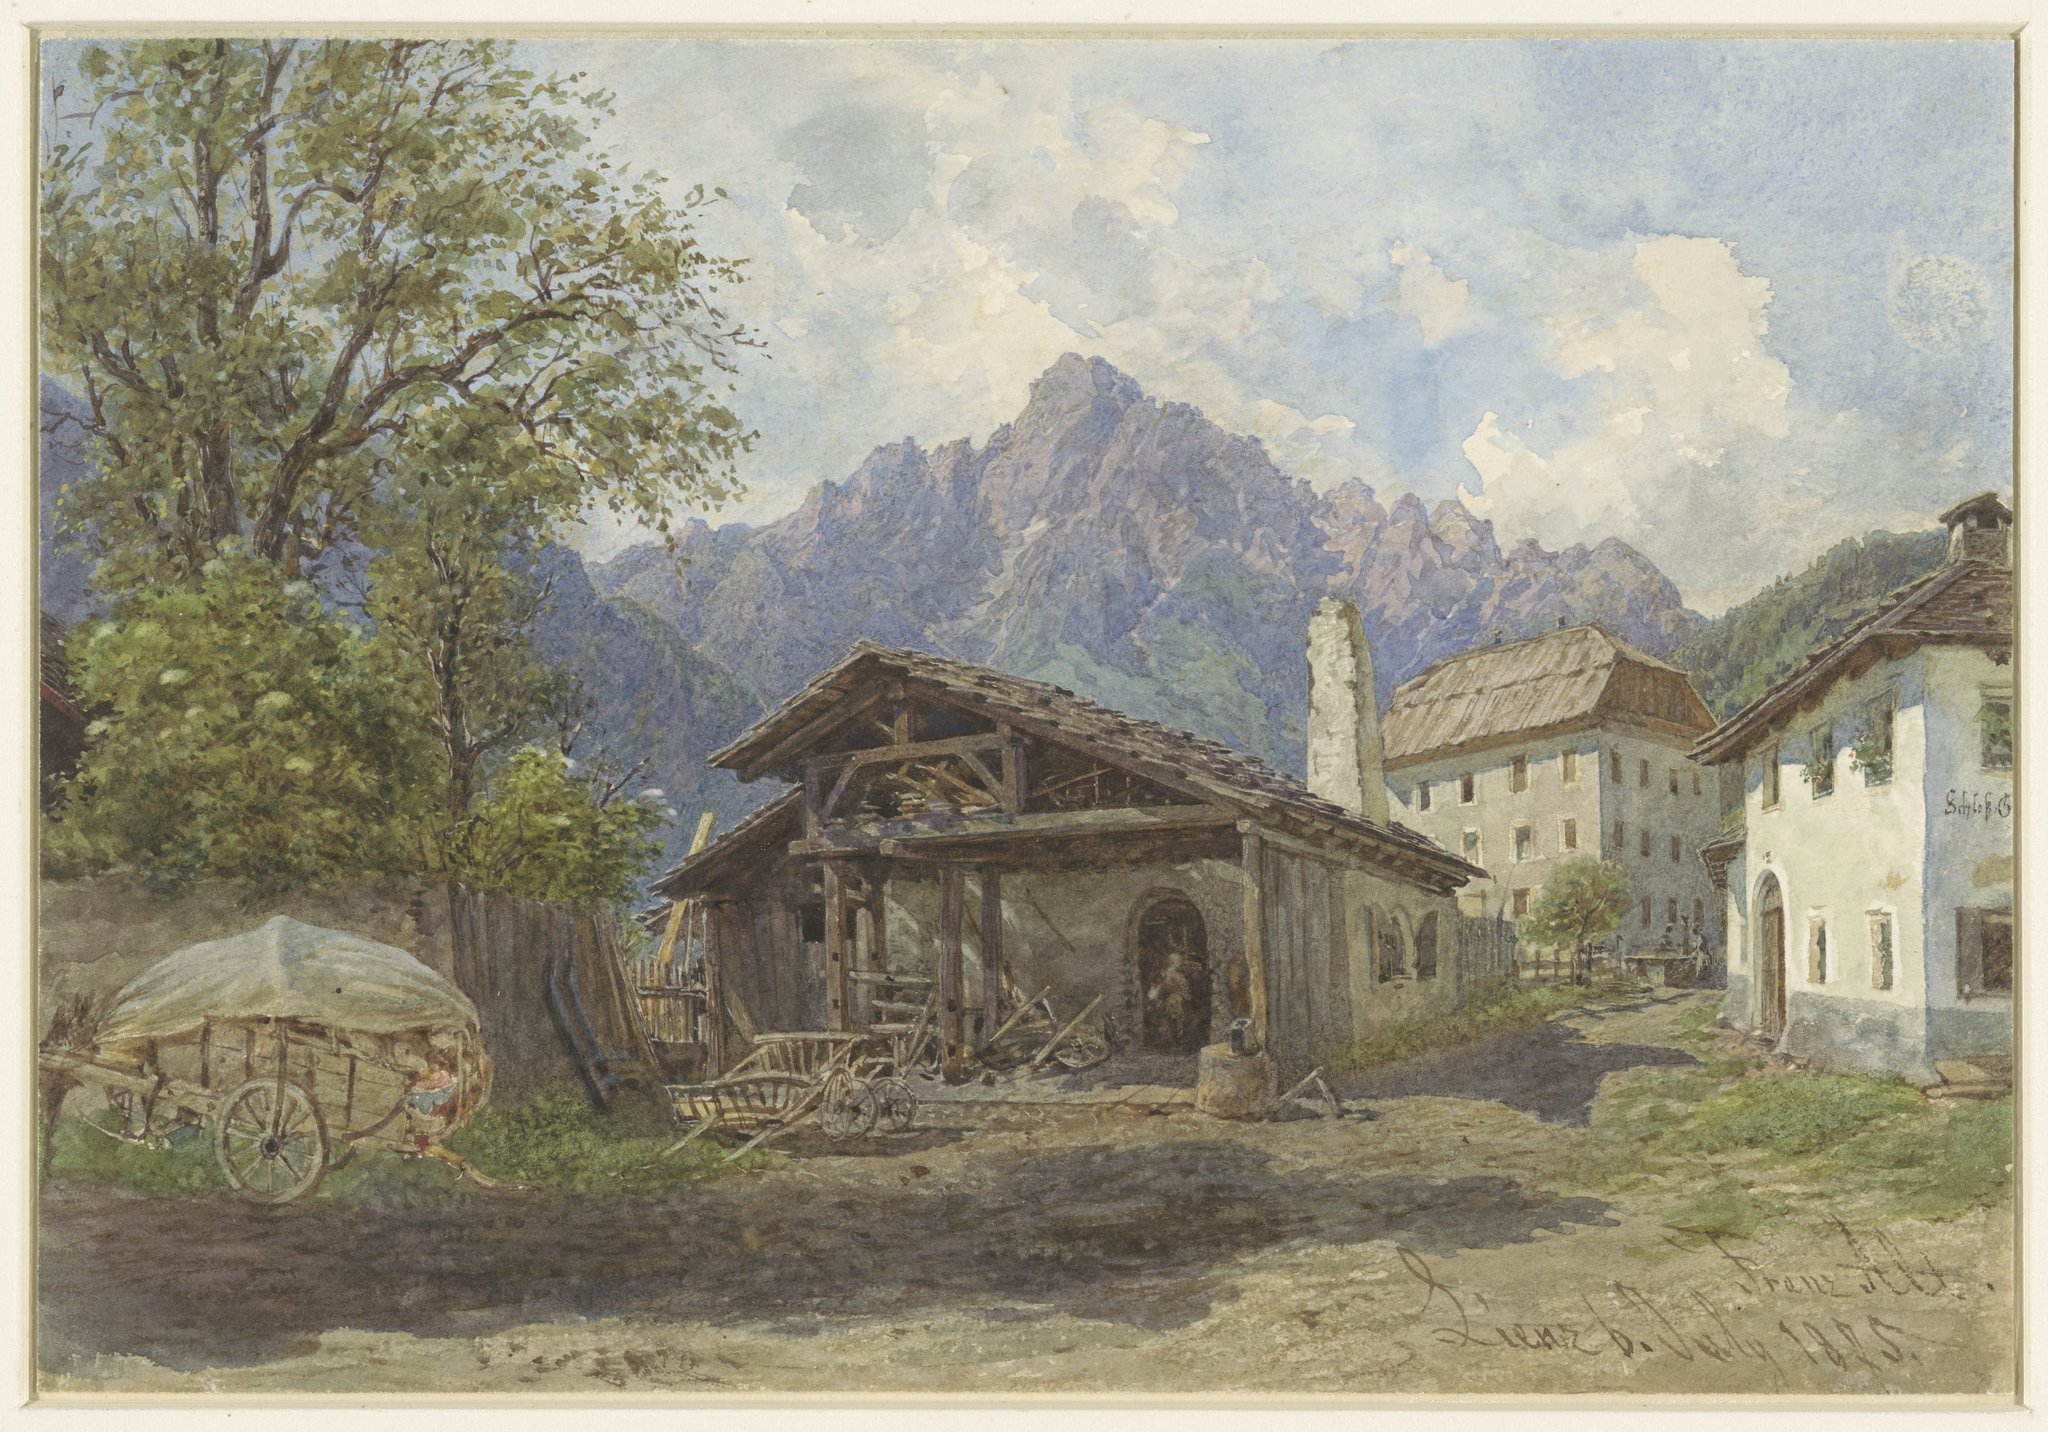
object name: drawing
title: Gezicht te Lienz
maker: franz alt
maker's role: draughtsman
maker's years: 1821-1914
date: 1875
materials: paper, watercolor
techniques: brush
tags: mountain-range, snow peaks, prospect of village, silhouette of village (+ city(-scape) with figures, staffage)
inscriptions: date: ‘Lienz 6. July 1875’